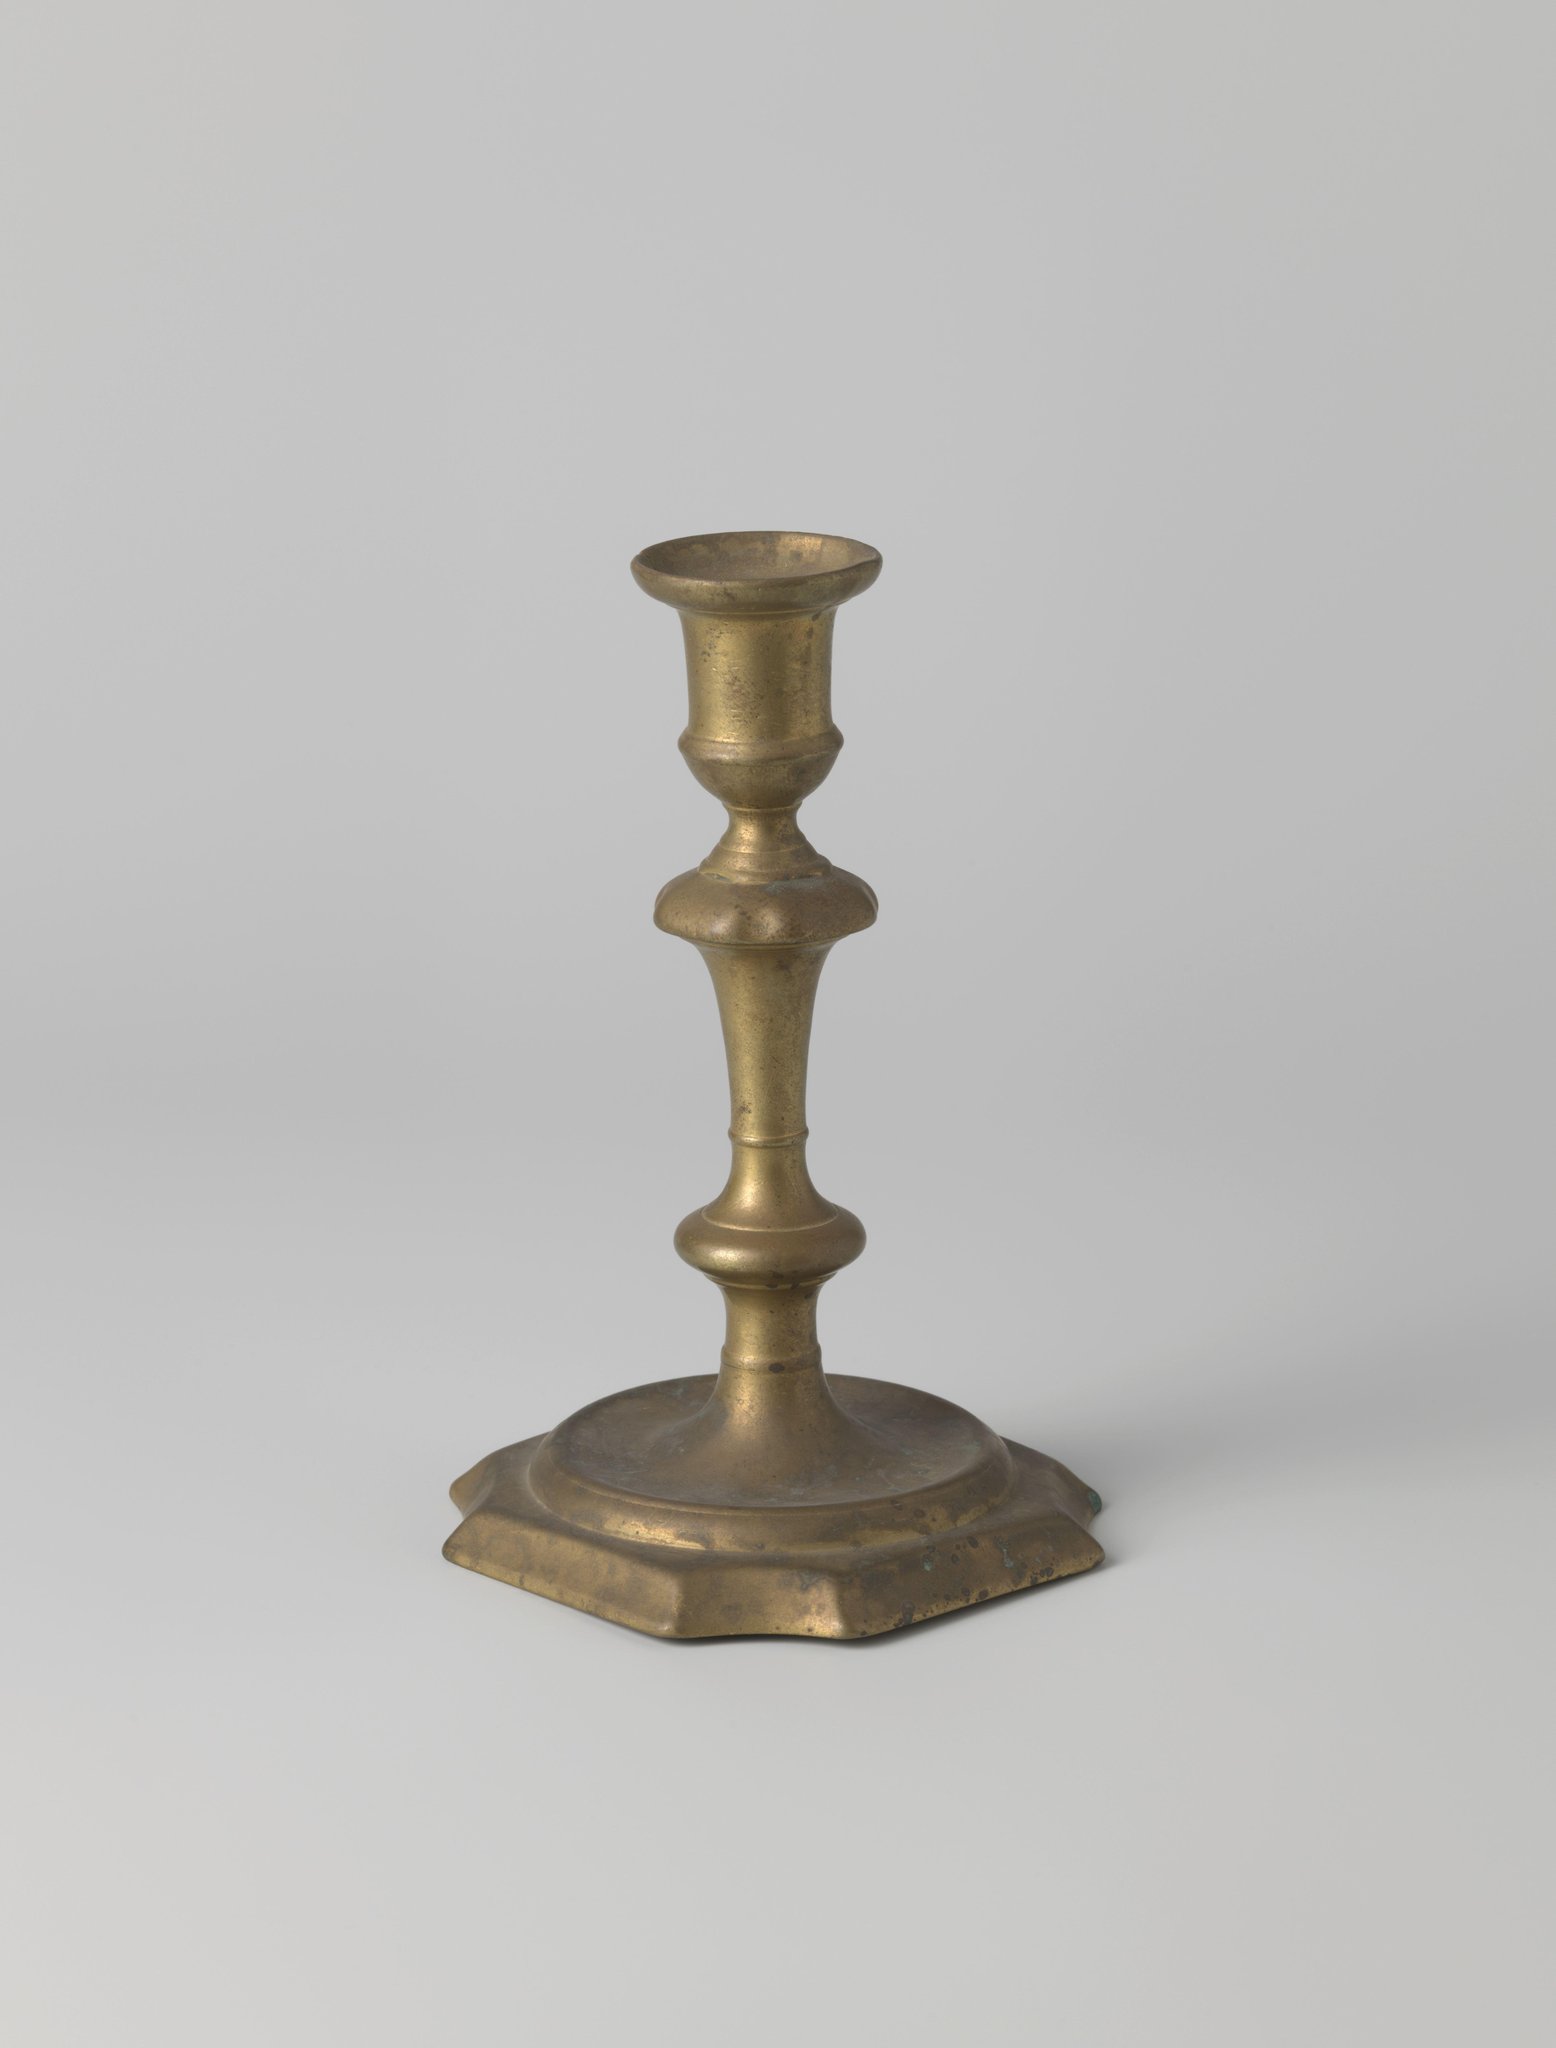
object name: candlestick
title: Kandelaar van messing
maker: Anonymous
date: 1725-1750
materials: brass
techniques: brazing, casting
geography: england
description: De kandelaar is uit twee delen samengesteld: de voet en de stam met de kaarsenhouder. De stam met de houder zijn in twee verticale helften gegoten, waarvan aan beide zijden nog de gietnaden te zien zijn. De platte vierkante voet heeft holrond afgeschuinde hoeken en is naar het midden toe voorzien van een iets opstaande ronde rand. Aldus kan dit deel als vetvanger dienst doen. De stam heeft een knoop en een zich naar boven toe verbredende baluster, welke in doorsnede het profiel herhaalt van de voet. De cylindrische kaarsenhouder heeft een uitstekende opstaande rand.